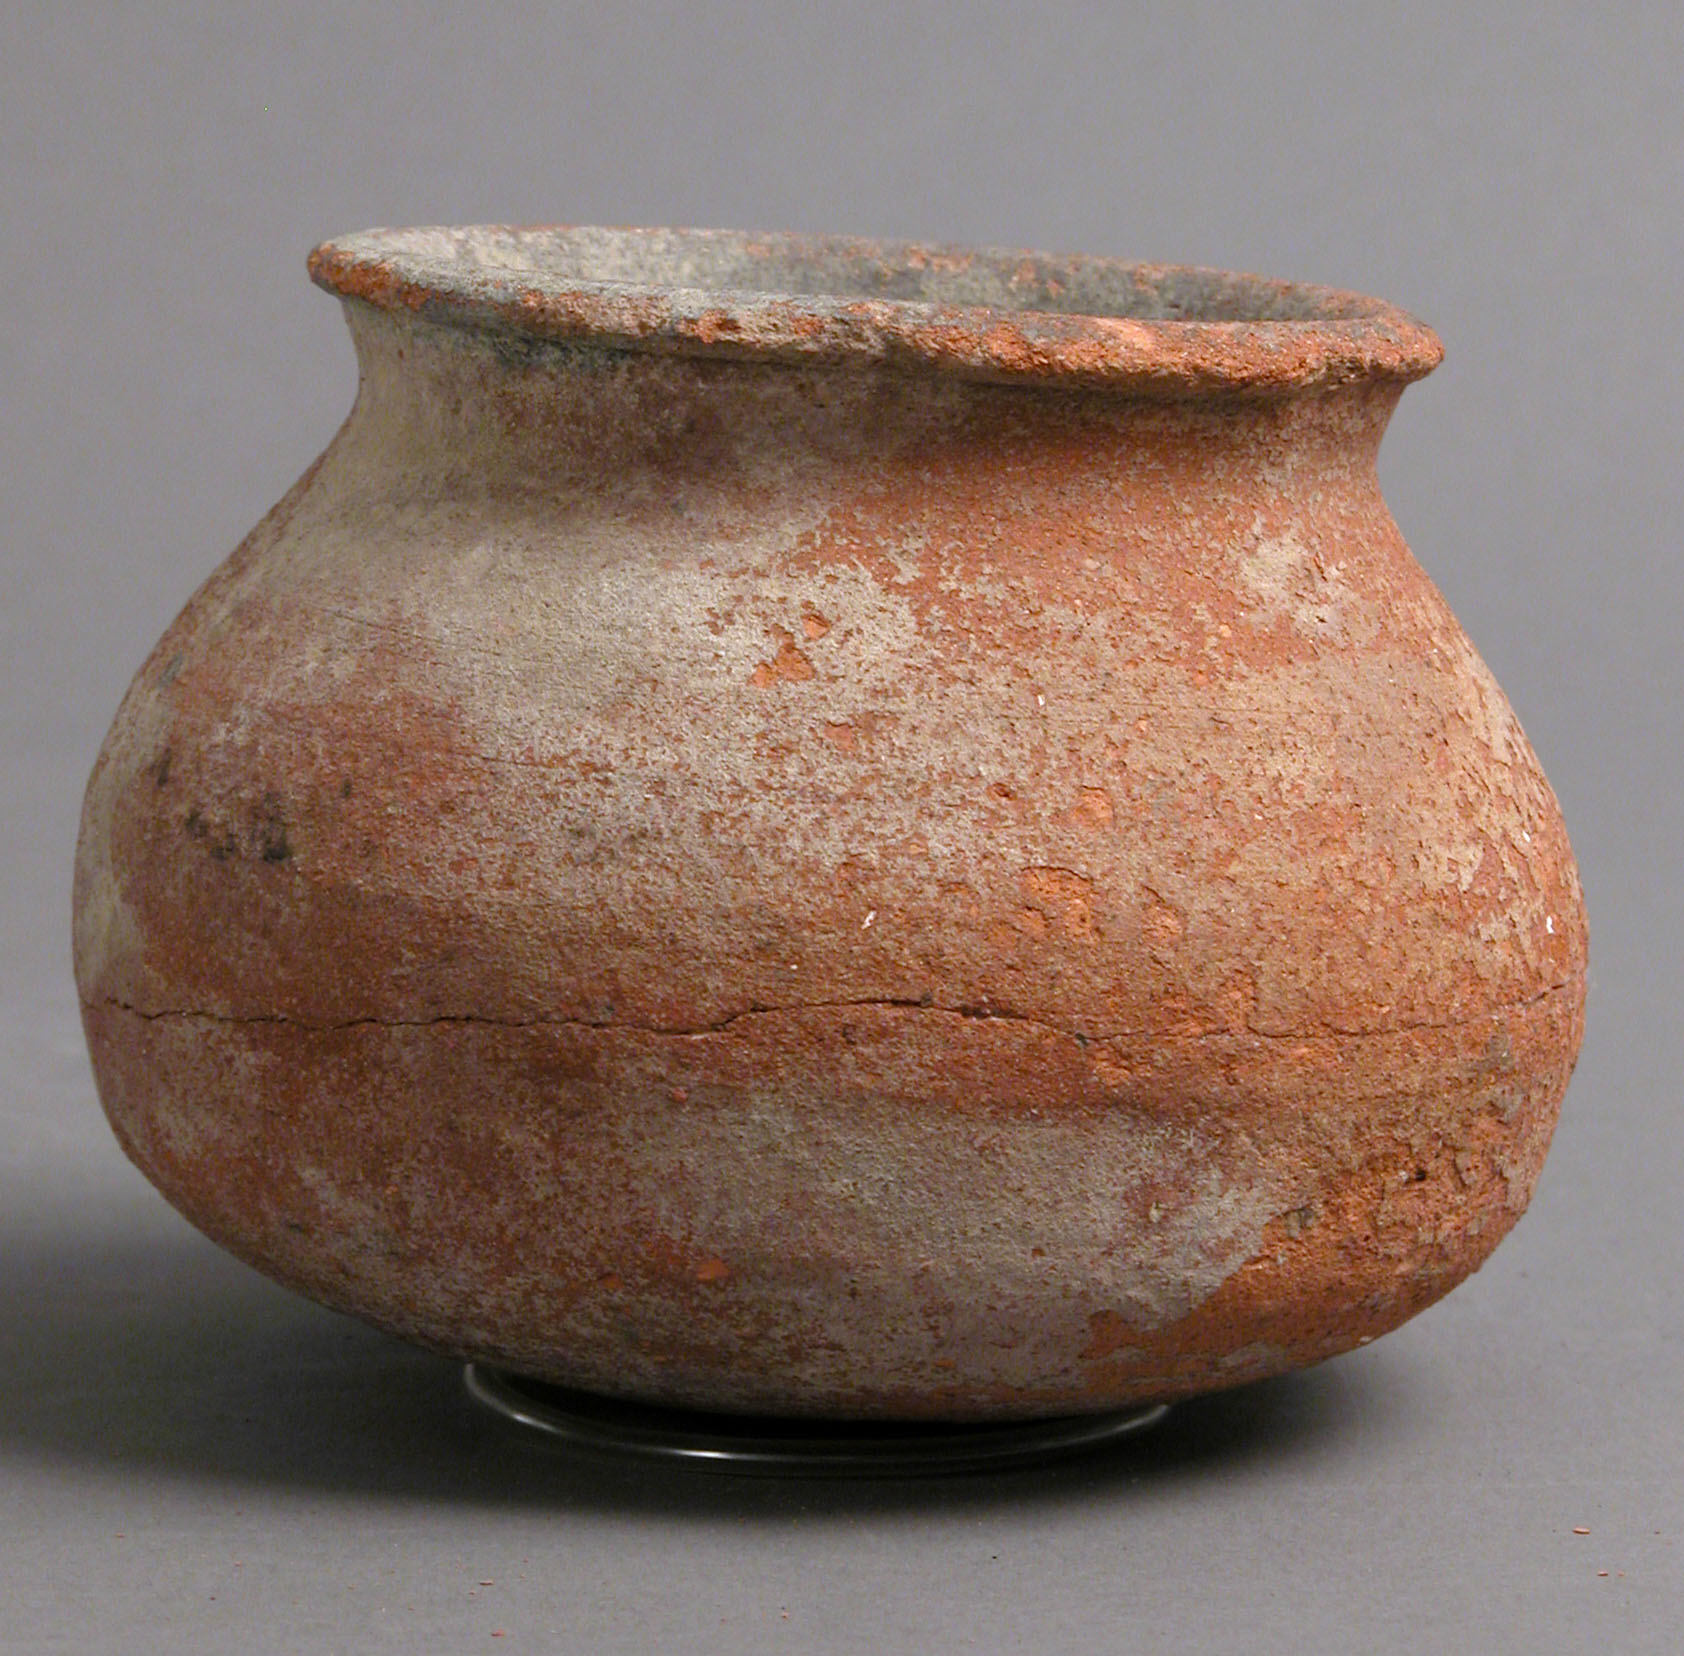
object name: pot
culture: coptic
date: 301-700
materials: earthenware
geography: egypt